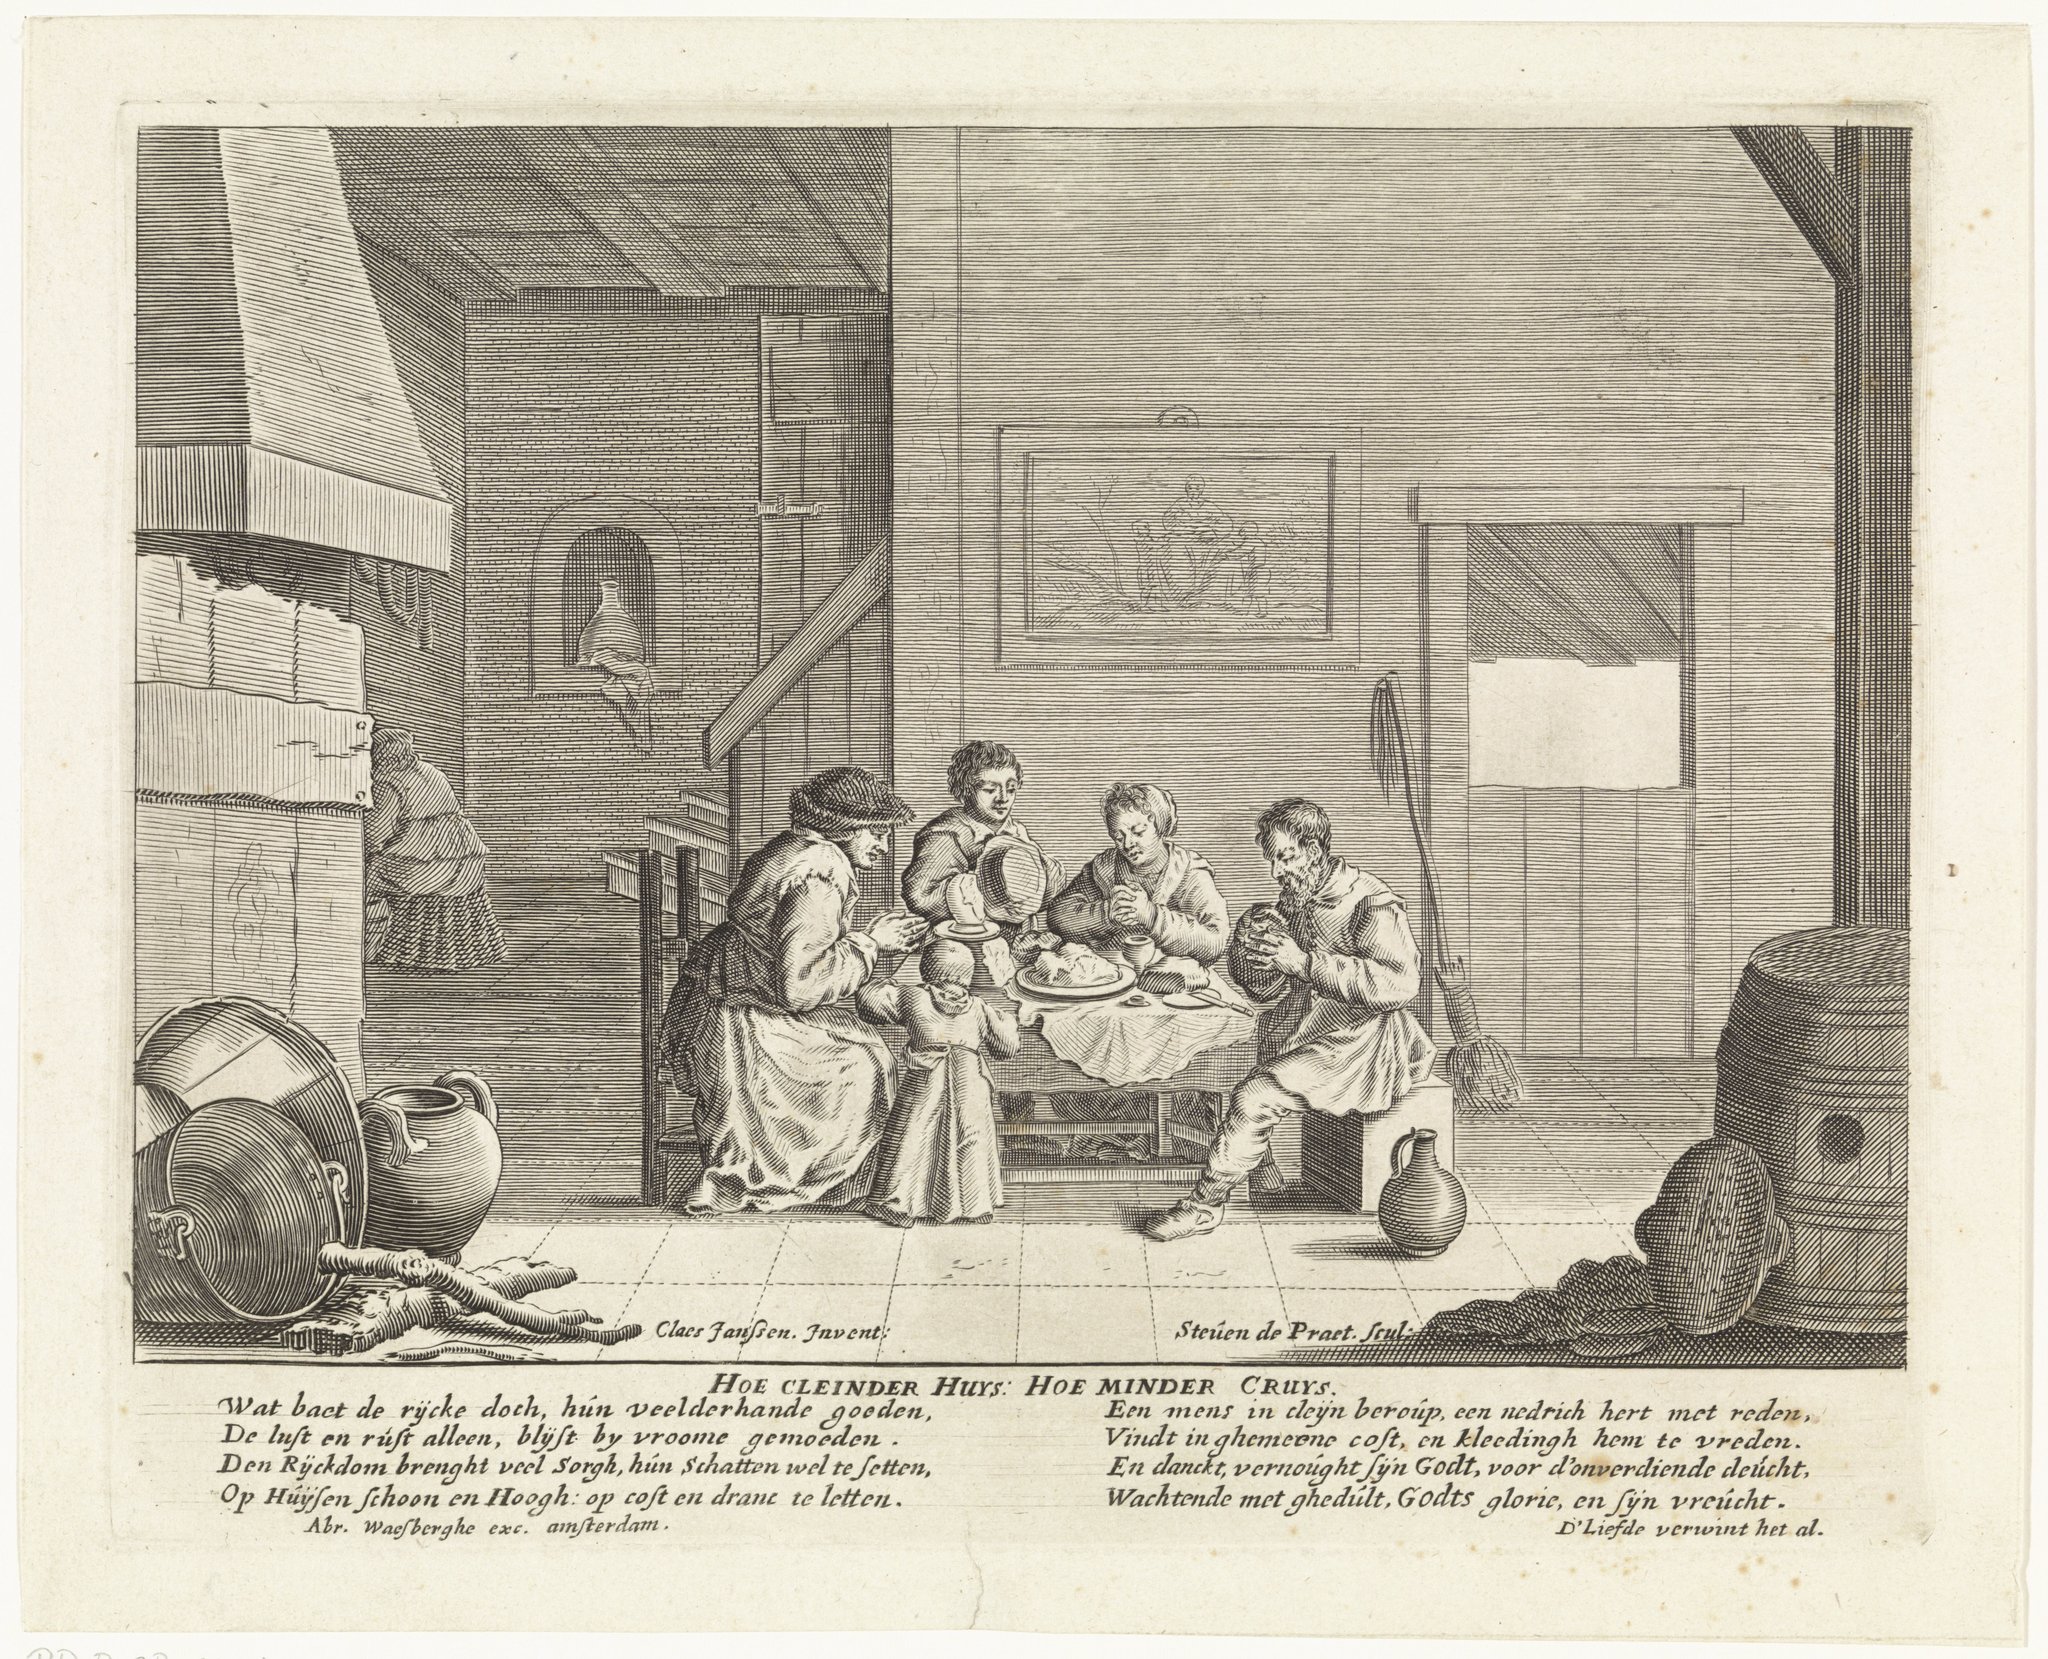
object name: print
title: Het Gebed voor de maaltijd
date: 1635-1645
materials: paper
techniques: engraving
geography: danzig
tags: devotion, piety; 'divotione' (ripa), prayer at table, saying grace, humility; 'humiltà' (ripa), the poor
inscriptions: collector's mark: Lugt 240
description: Een gezin bestaande uit vader, moeder en drie kinderen zit met gevouwen handen rond een gedekte tafel in een sober vertrek. De twee jongste kinderen staan. Op de voorgrond liggen gebruiksvoorwerpen: een houten kuip, een ketel, een kruik, een wijnvat en een zeef. Op de achtergrond zit een man, op de rug gezien, op een omgekeerde mand bij de haard. Onder de afbeelding een gedicht in het Nederlands.